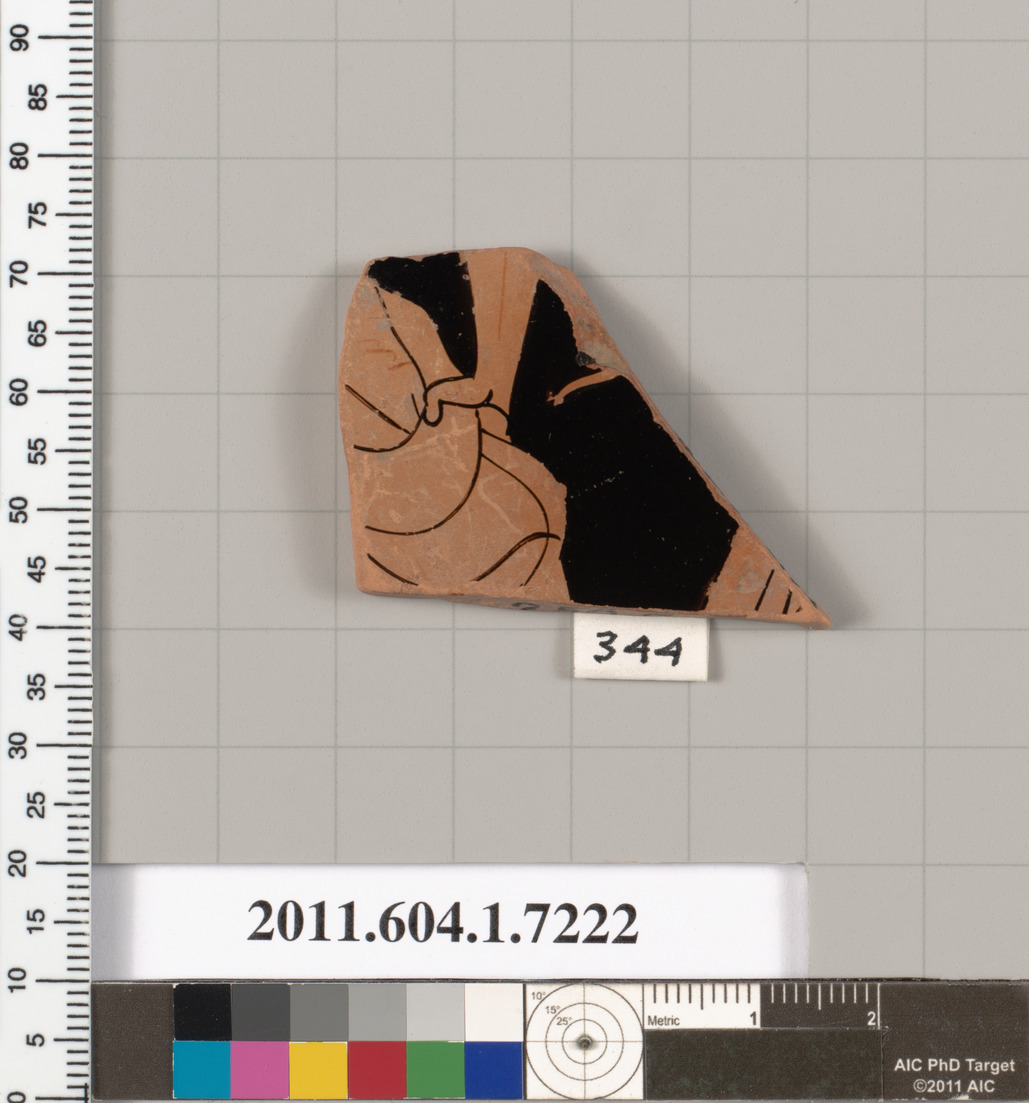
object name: kylix fragment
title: Terracotta fragment of a kylix (drinking cup)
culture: greek, attic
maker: makron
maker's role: artist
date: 500-480 BCE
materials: terracotta